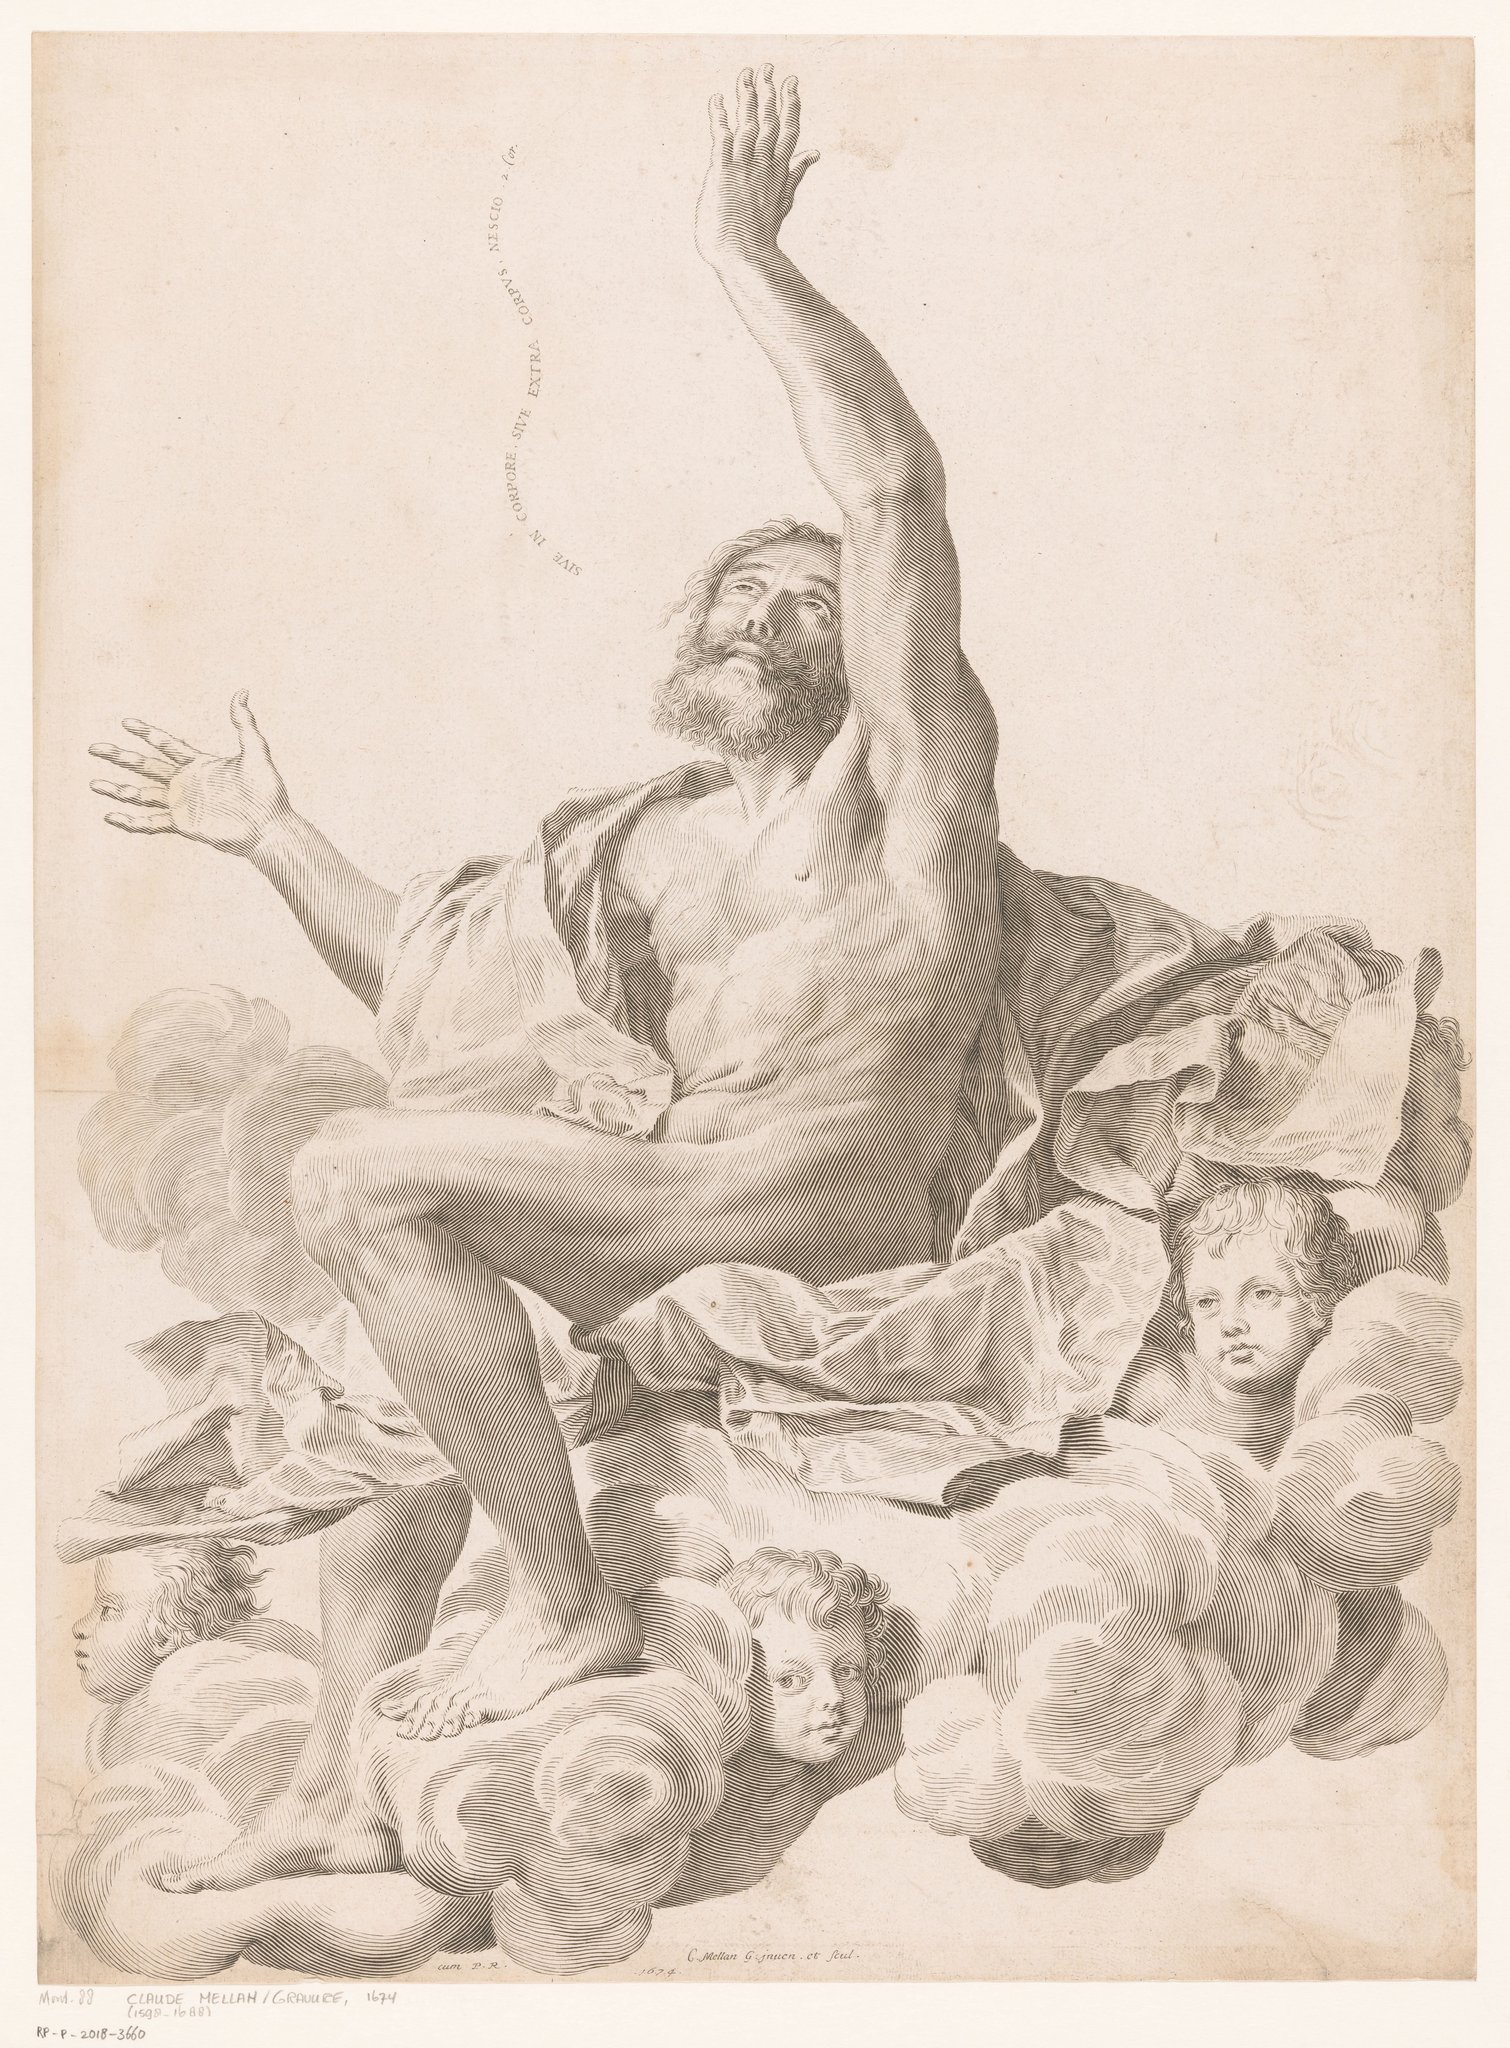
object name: print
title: Extase van Paulus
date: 1674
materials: paper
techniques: engraving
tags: paul's ecstatic vision: he is borne aloft by (three) angels (2 corinthians 12:1-3), the apostle paul of tarsus; possible attributes: book, scroll, sword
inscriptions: collector's mark: Lugt 2228